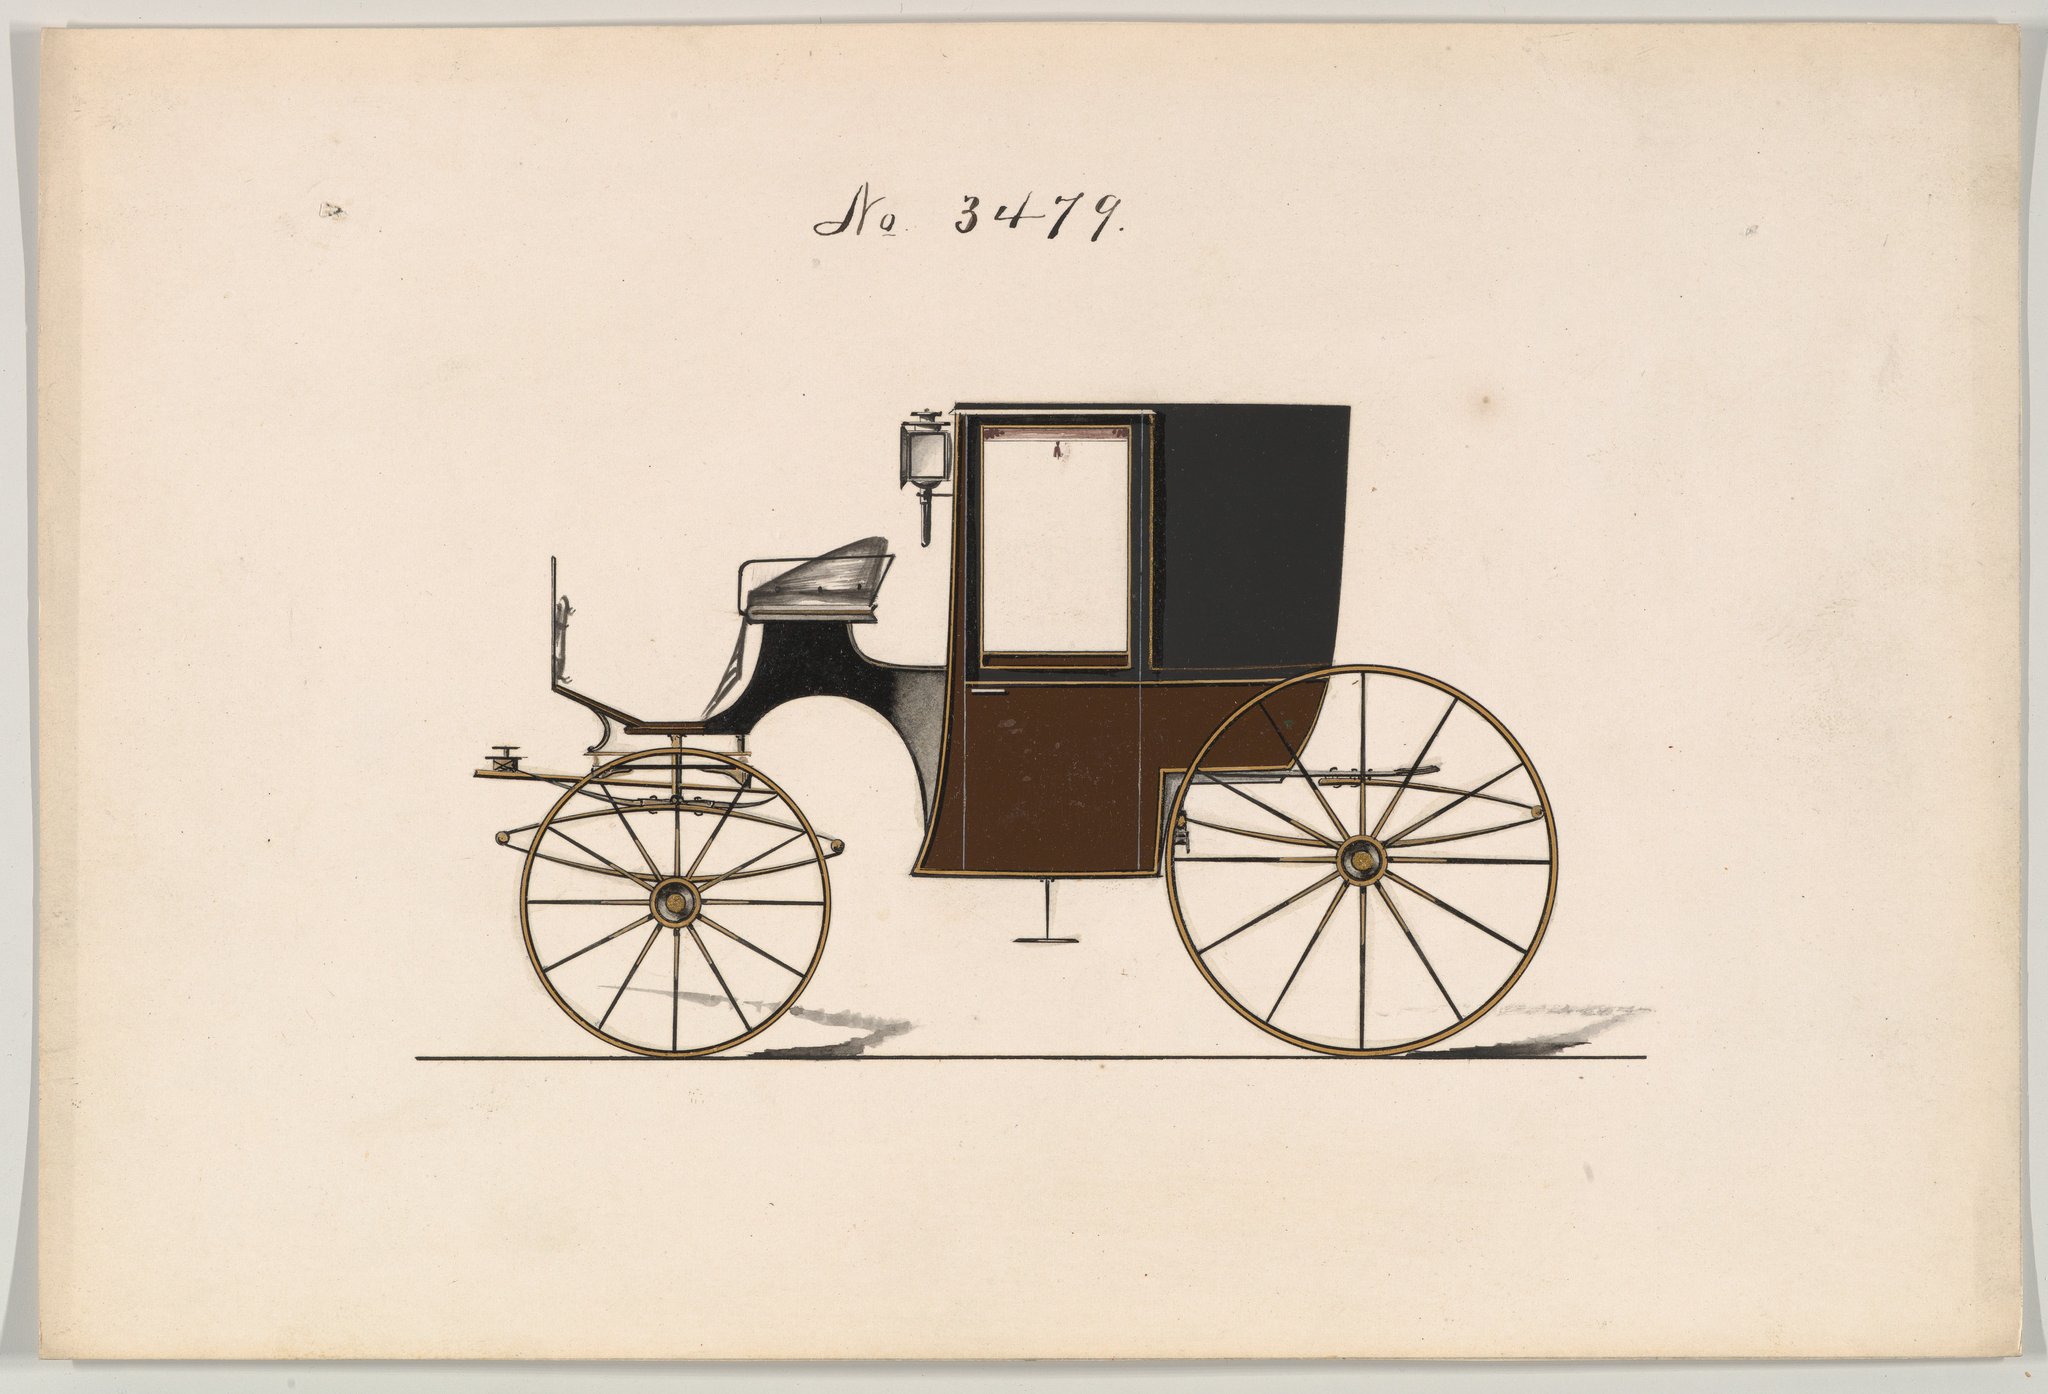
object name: drawing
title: Brougham #3479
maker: brewster & co.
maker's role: manufacturer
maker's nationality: american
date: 1878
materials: gouache, gum arabic, ink, watercolor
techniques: pen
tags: carriages